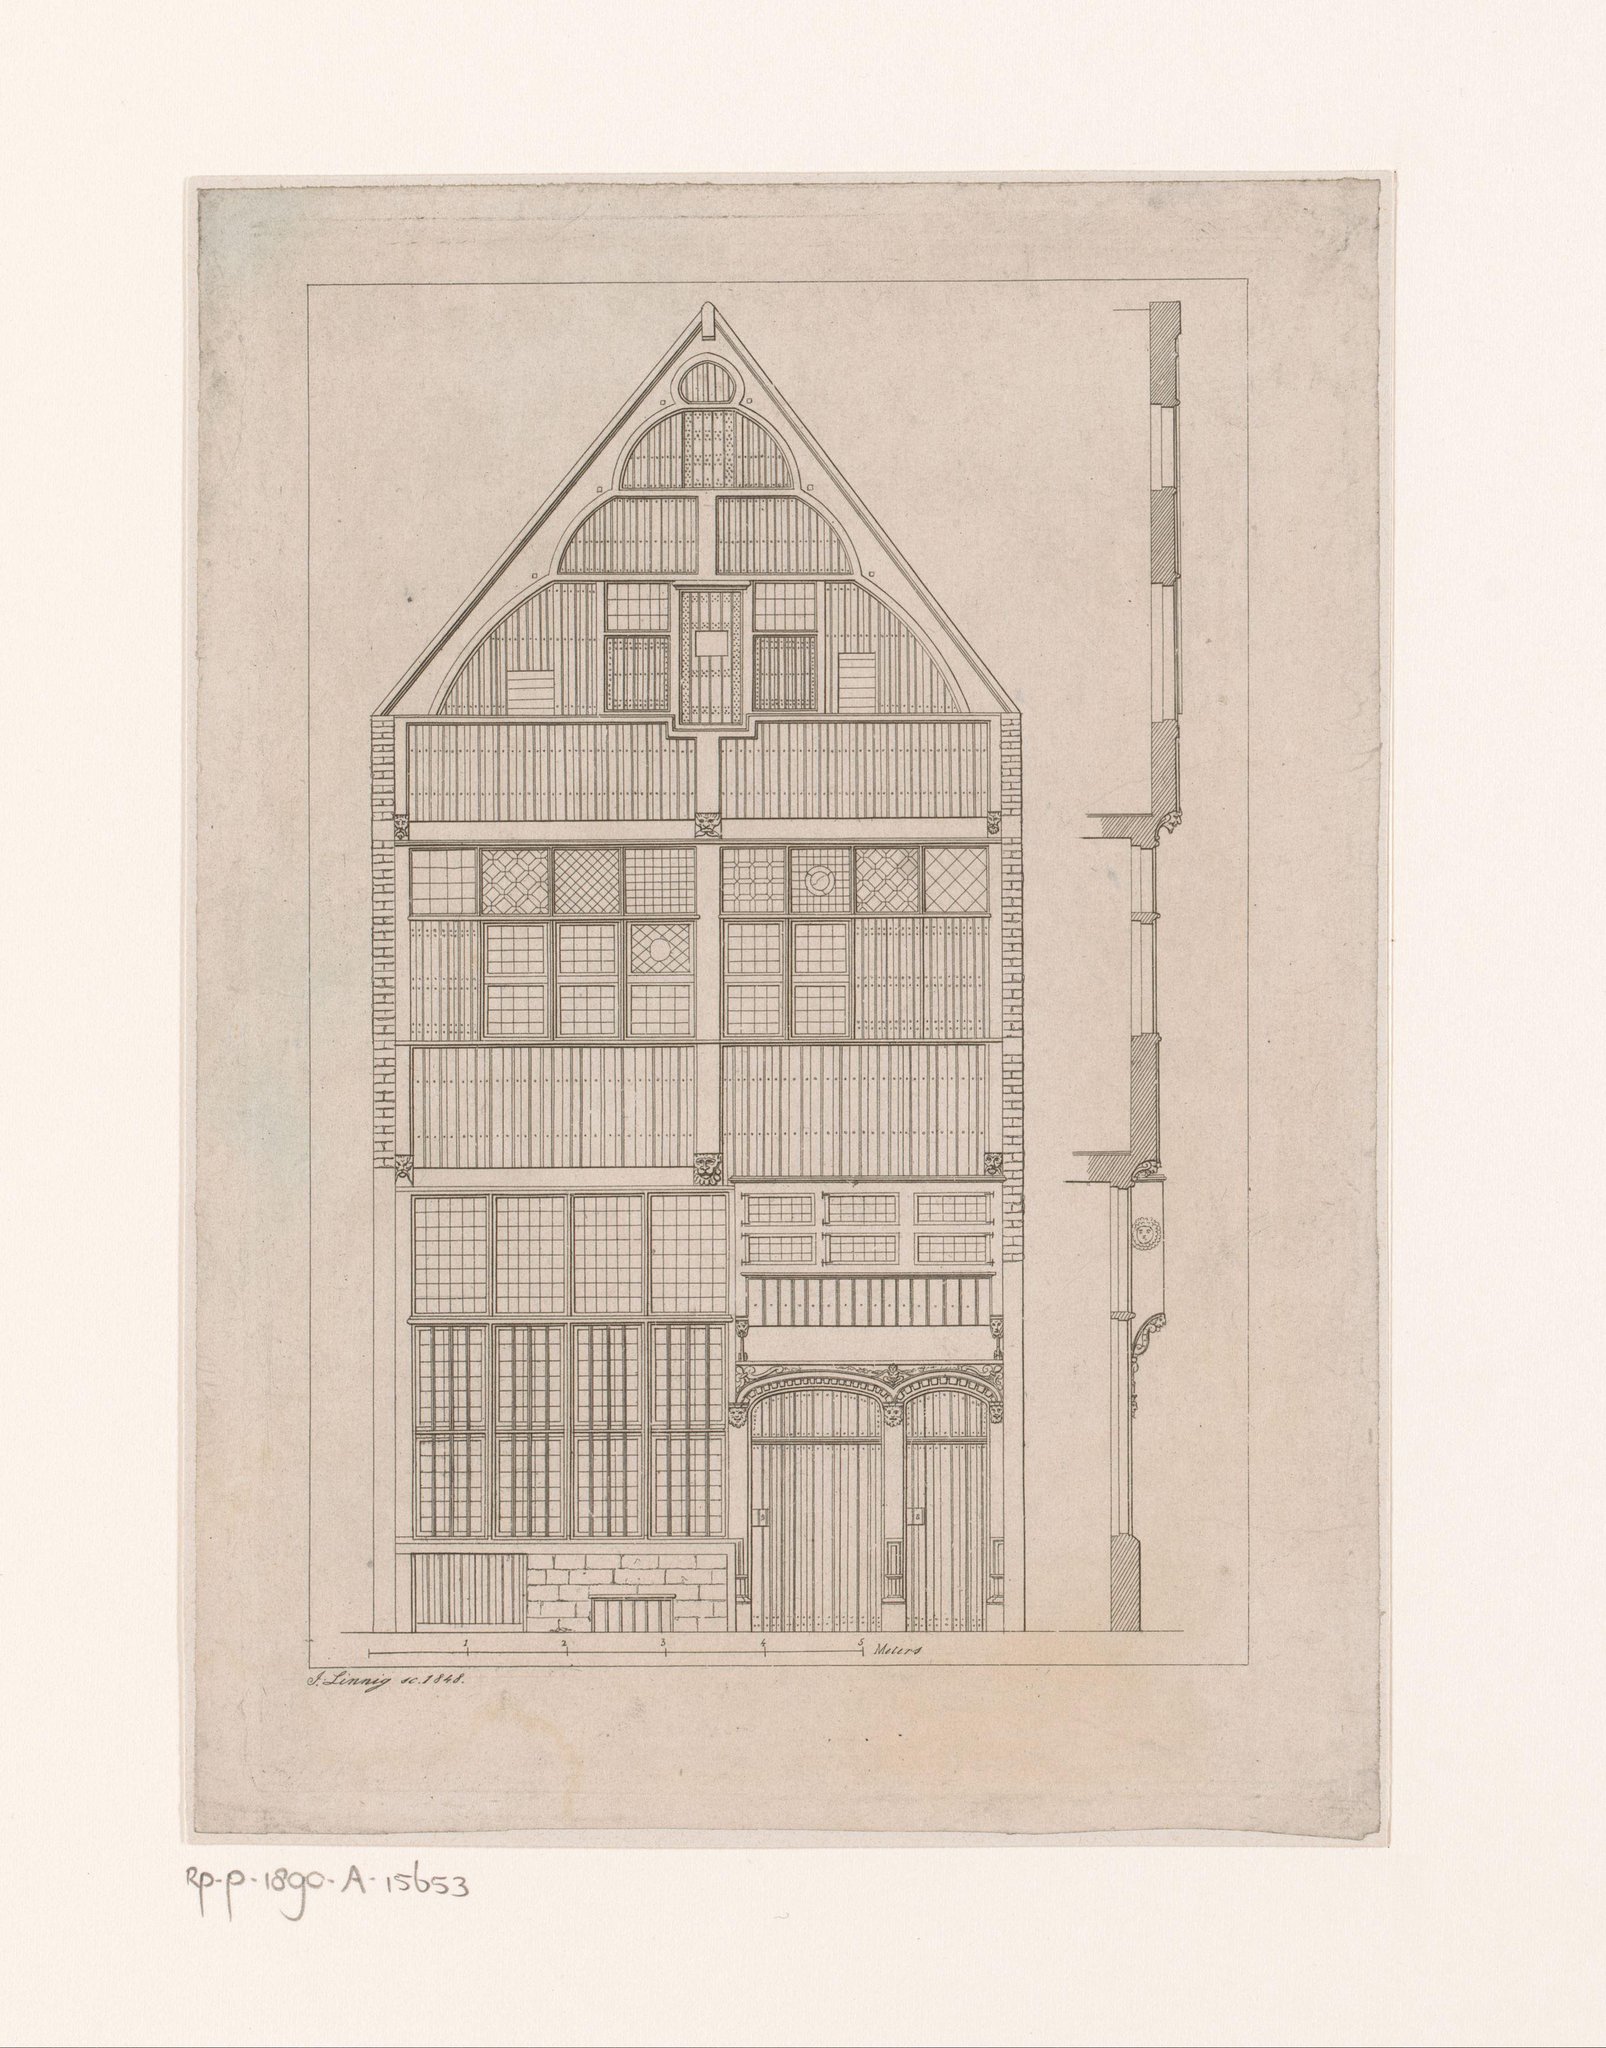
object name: print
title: Houten gevel van een woning in de Saucierstraat in Antwerpen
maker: jean théodore joseph linnig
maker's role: draughtsman, print maker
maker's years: 1815-1891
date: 1848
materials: paper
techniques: etching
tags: façade (of house or building), antwerp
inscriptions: collector's mark: Lugt 2228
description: Volgens Hippert & Linnig is deze prent gebruikt in: Mertens, F.H. en K.L. Torfs. Geschiedenis van Antwerpen. 5 dln. Antwerpen: J.P. van Dieren, 1845-1853.